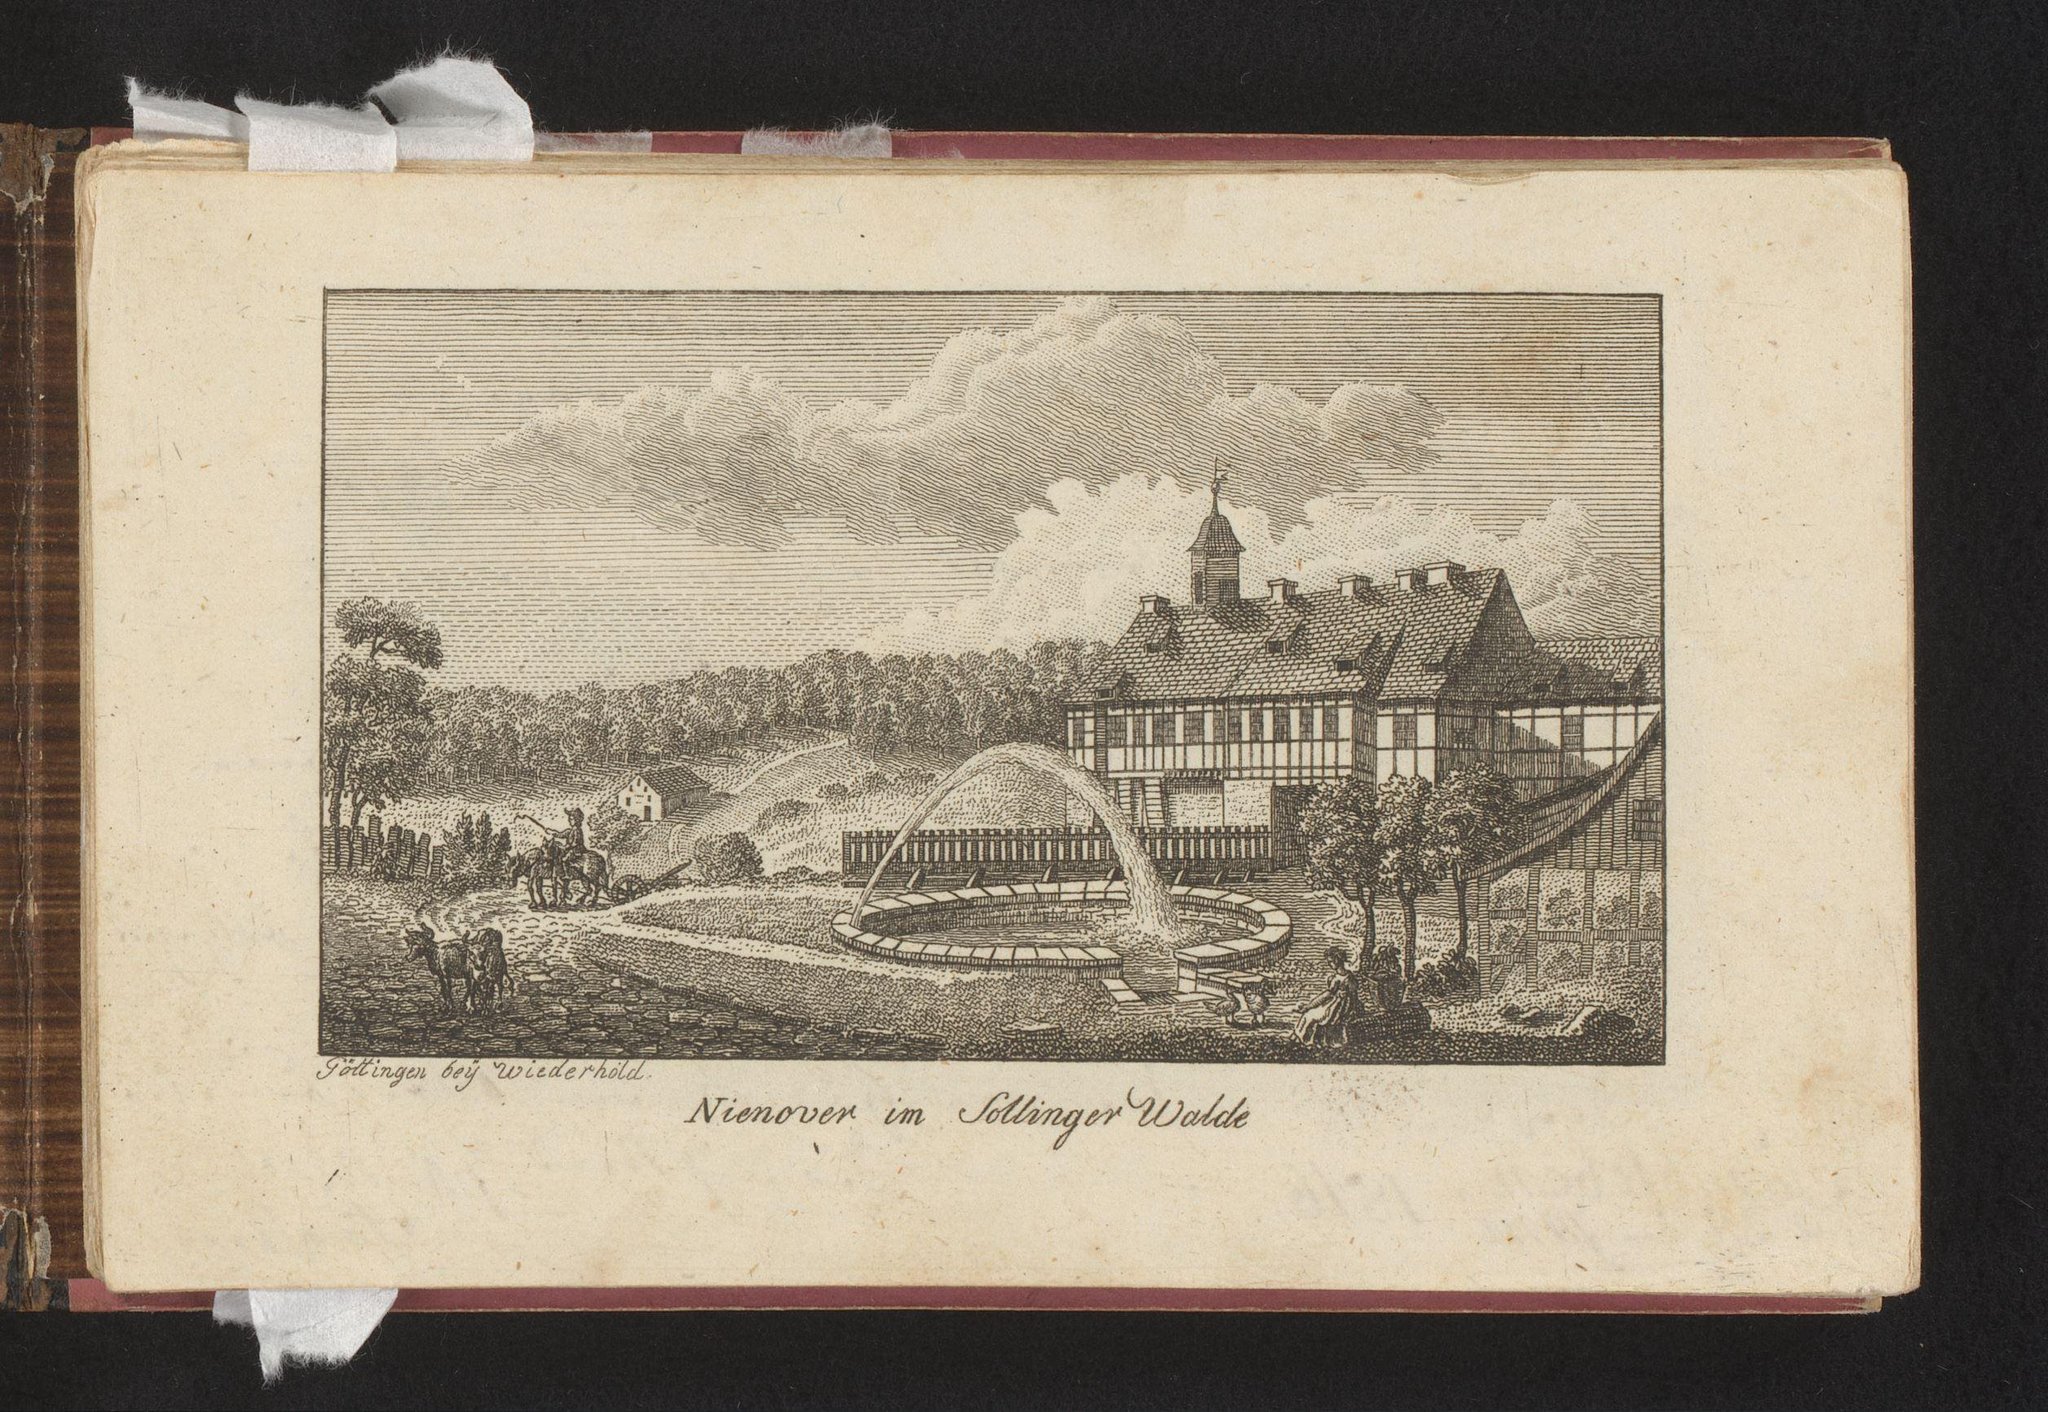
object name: print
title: Gezicht op Nienover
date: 1770-1816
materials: ink, paper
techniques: etching, writing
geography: gottingen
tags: 'album amicorum', 'stammbuch', village, forest, wood (+ landscape with figures, staffage)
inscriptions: tekst, verso, handgeschreven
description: Handgeschreven tekst in het Duits op het verso.